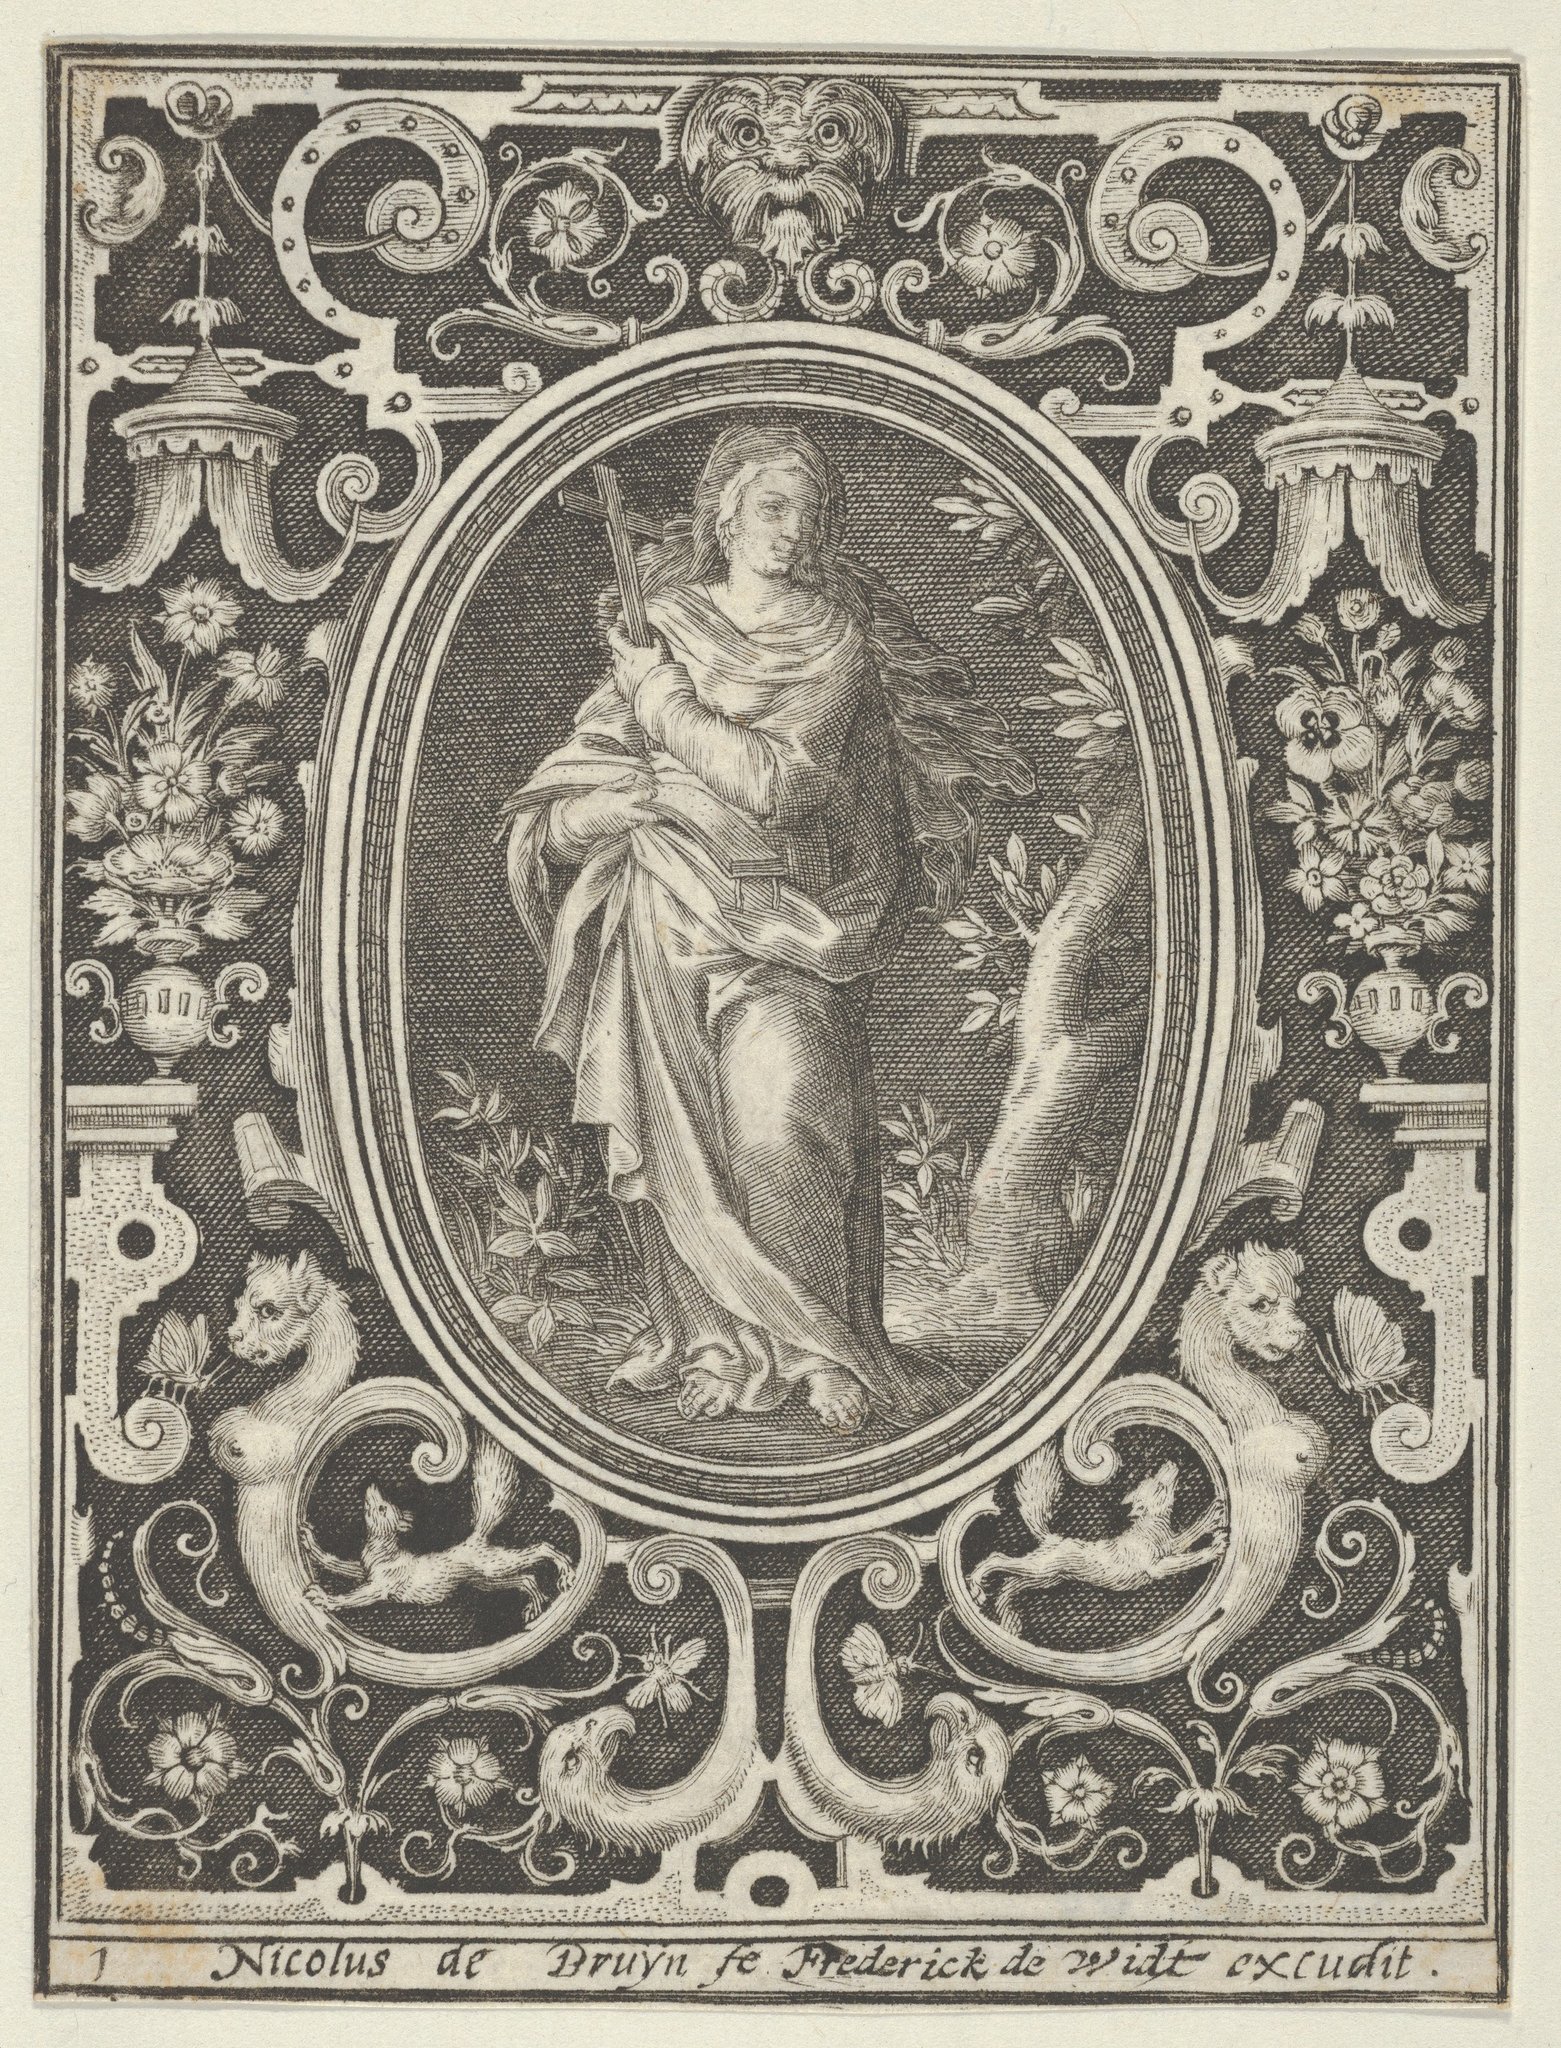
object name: print ornament architecture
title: Faith, from the Cardinal Virtues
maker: nicolaes de bruyn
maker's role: artist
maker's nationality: netherlandish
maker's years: 1571-1656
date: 1648-1656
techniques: engraving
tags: masks,grotesques,ornament,women,cross